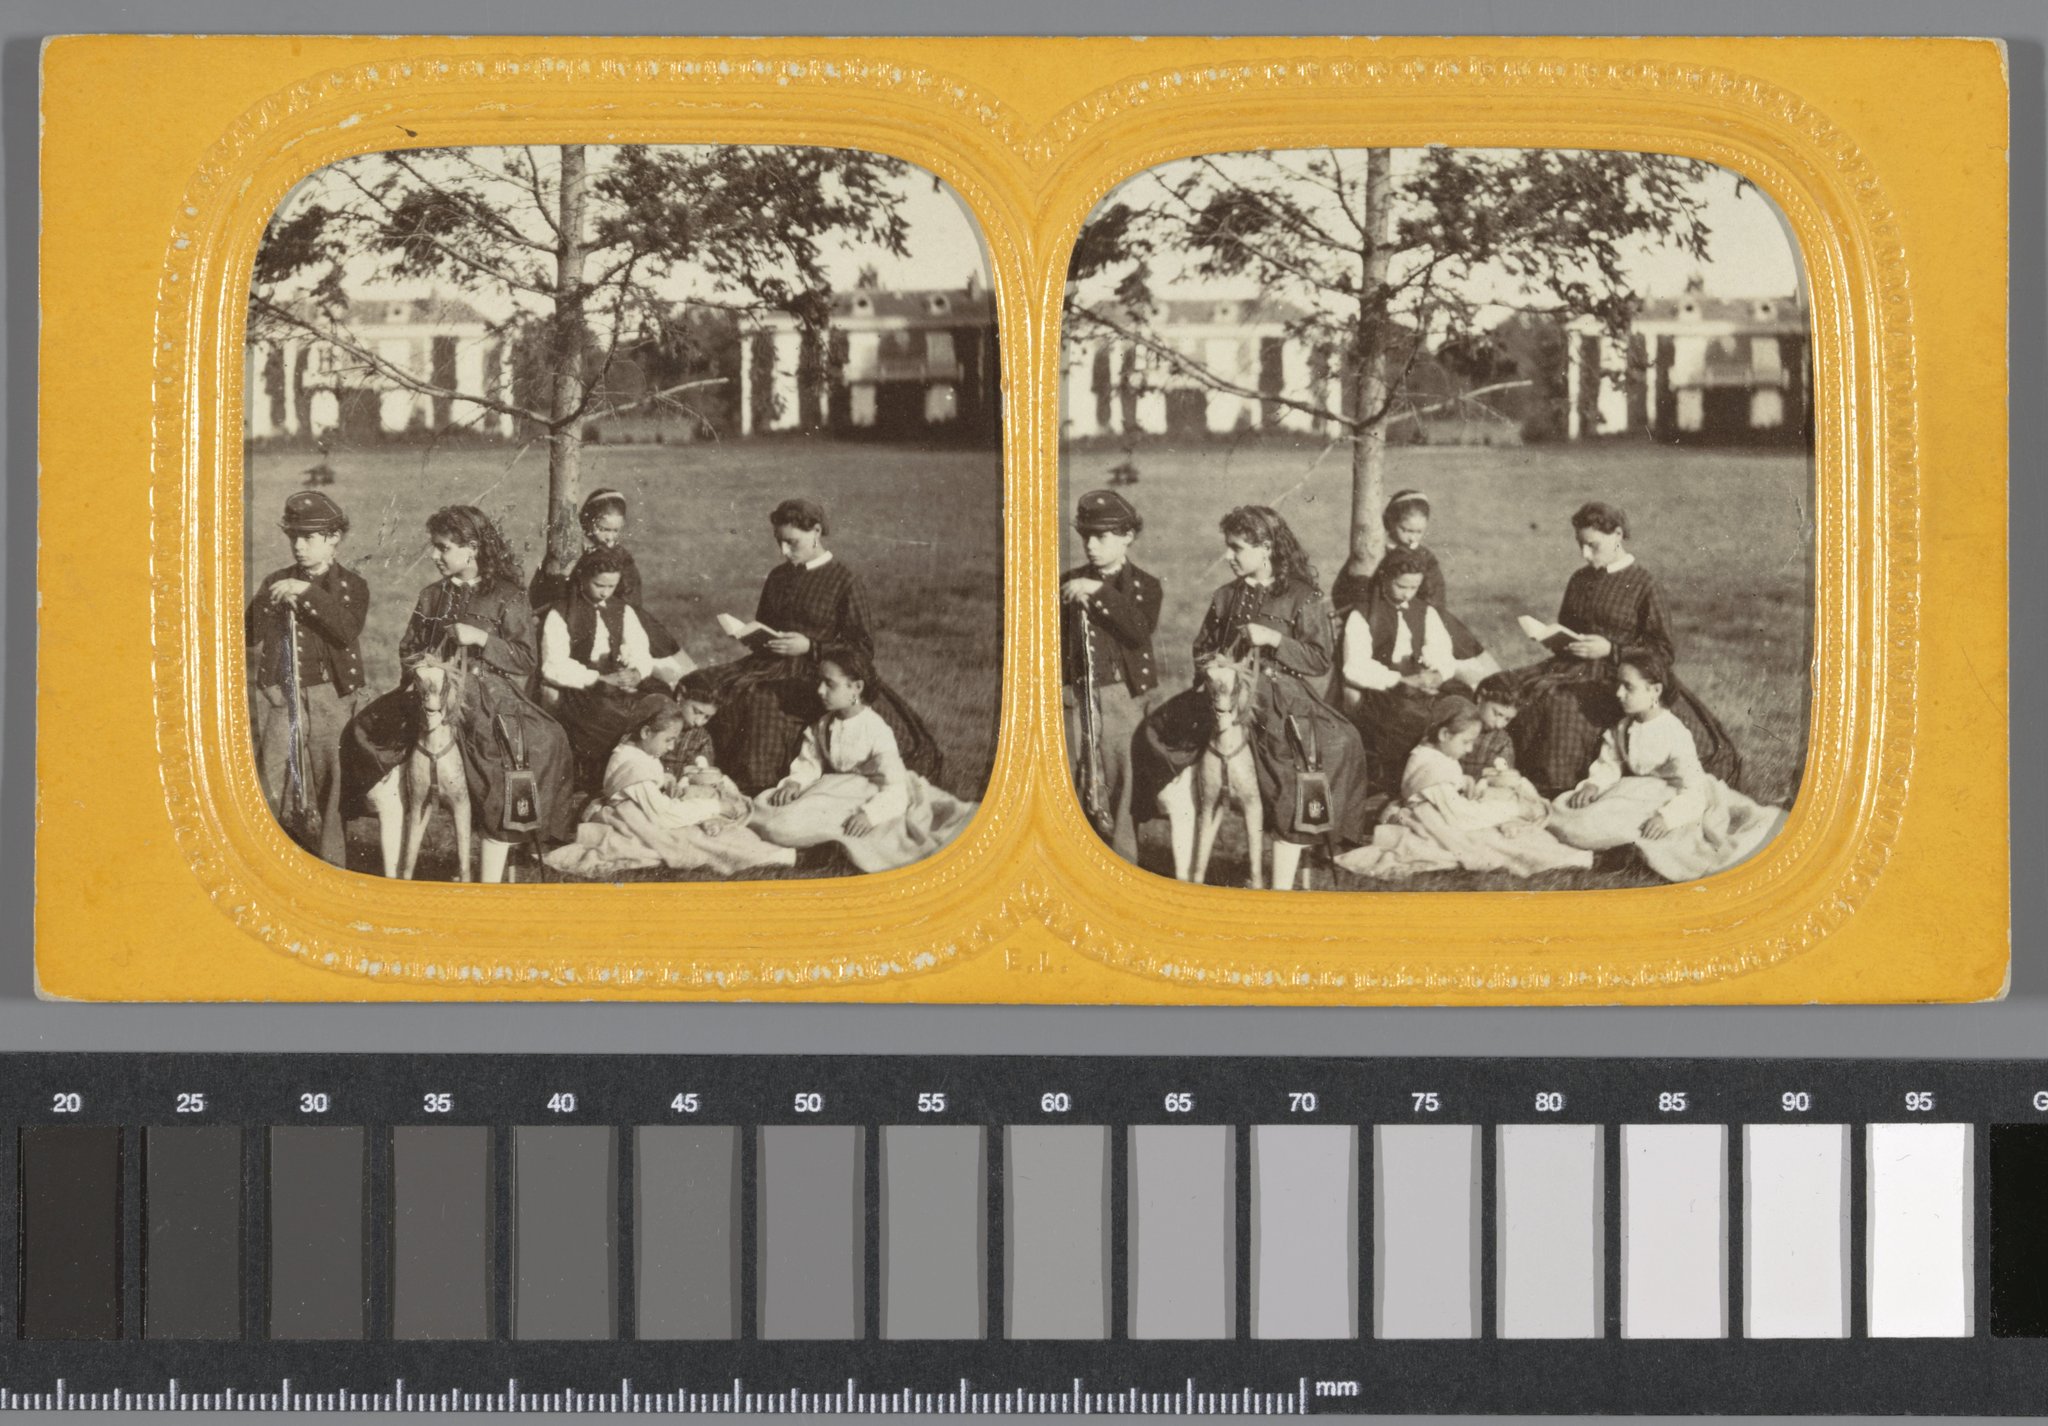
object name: tissue stereograph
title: Groep mensen in Paleistuin, Parijs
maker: e.l.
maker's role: publisher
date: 1860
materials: cardboard, photographic support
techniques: albumen print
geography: france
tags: paris